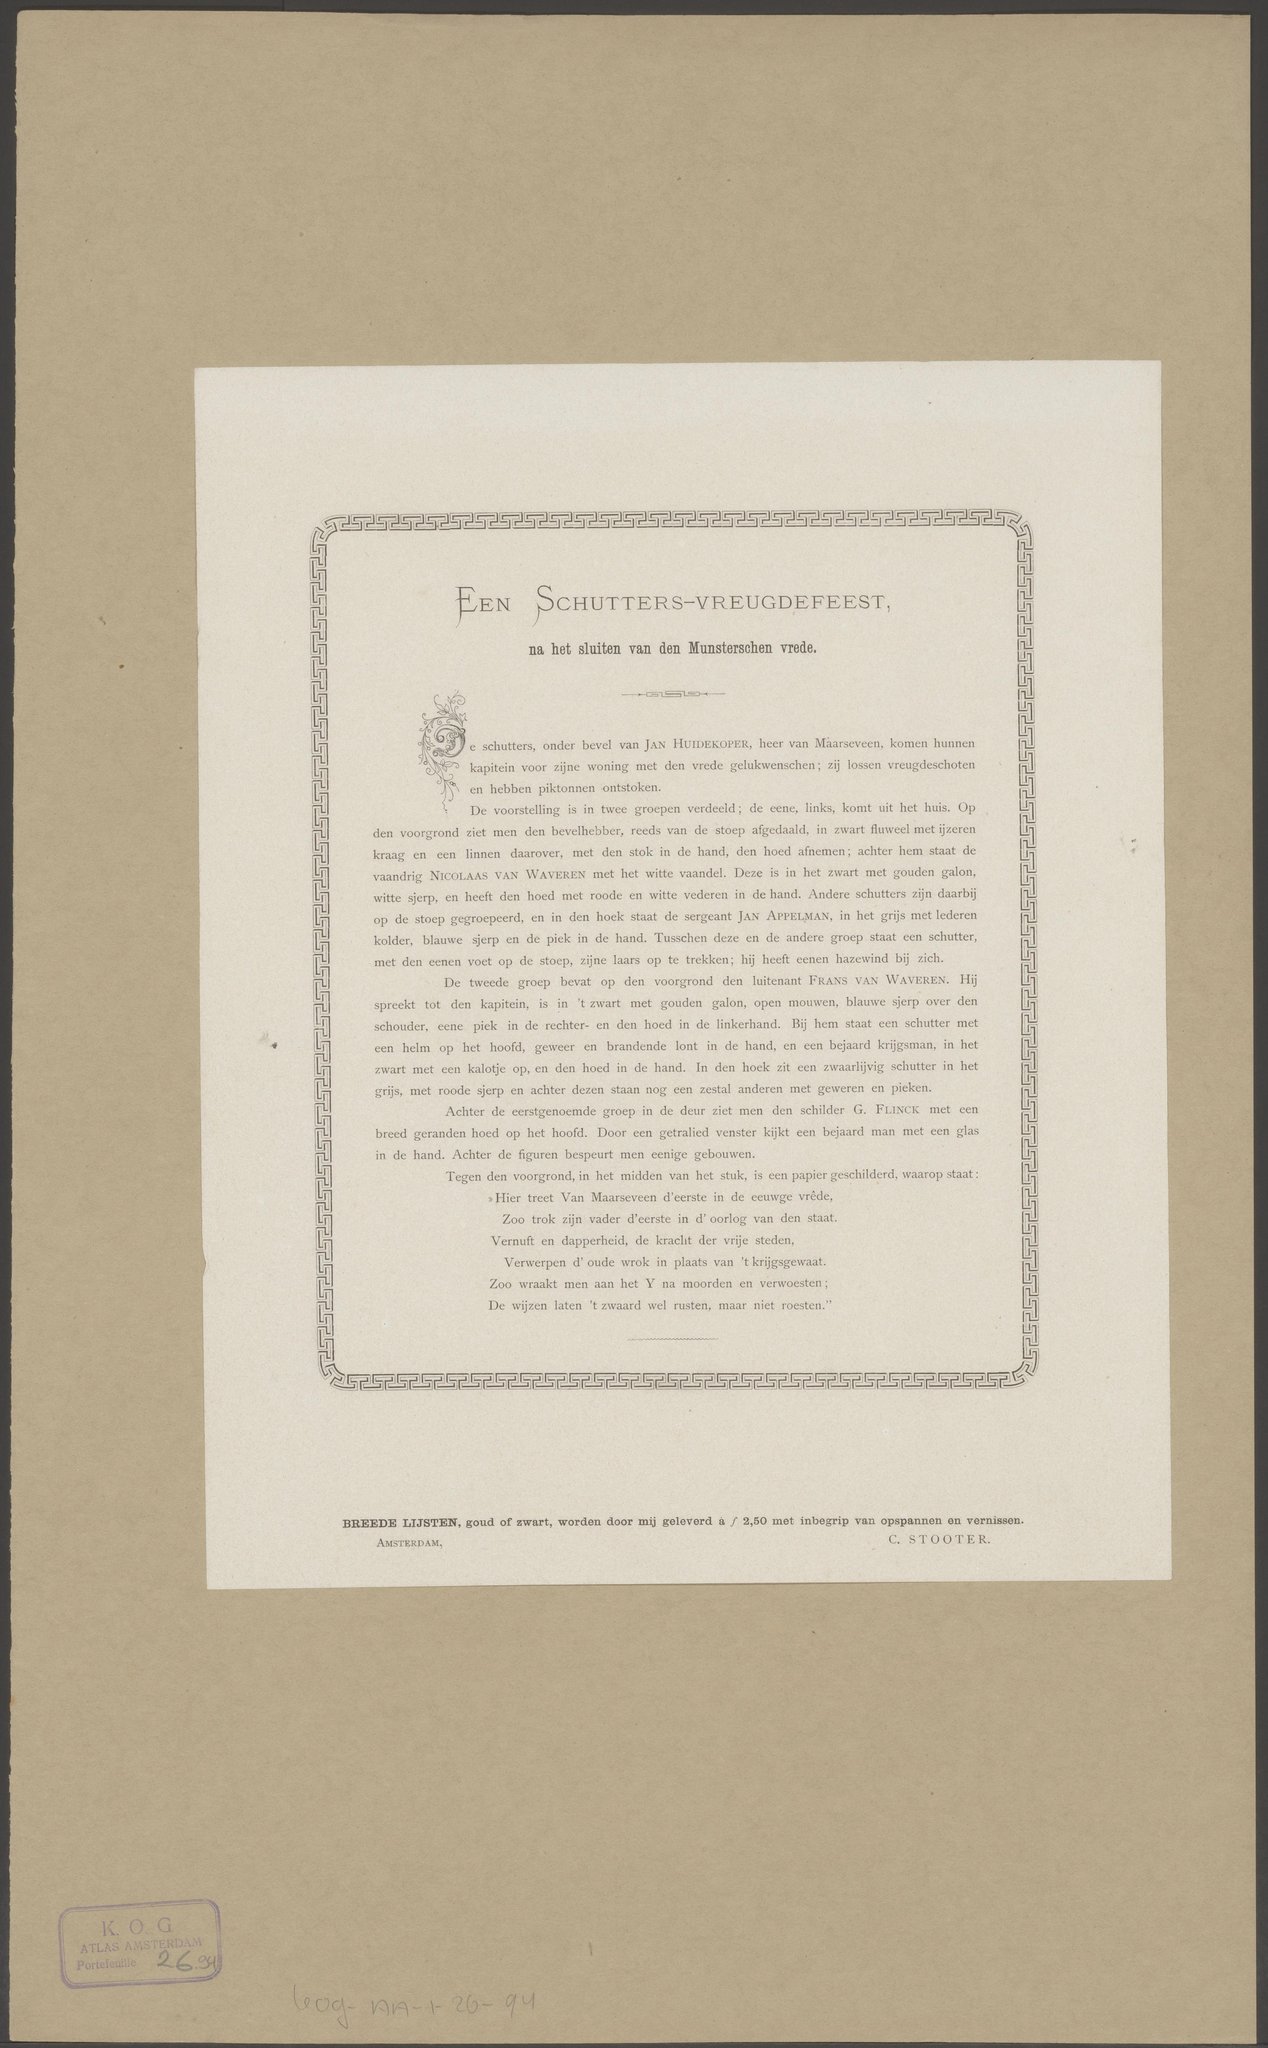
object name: text sheet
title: Een Schutters-vreugdefeest, na het sluiten van den Munsterschen vrede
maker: Anonymous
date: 1825-1875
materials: paper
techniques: letterpress printing, printing block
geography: netherlands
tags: cleves, draughtsman, govert flinck, mayor, joan huydecoper van maarseveen (i), historical persons, warfare; military affairs (+ citizen soldiery, civil guard, citizen militia), amsterdam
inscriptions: collector's mark: Lugt 1641b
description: Onderwerpsrubriek binnen de Atlas Amsterdam: Herinneringen aan de Schutterij.